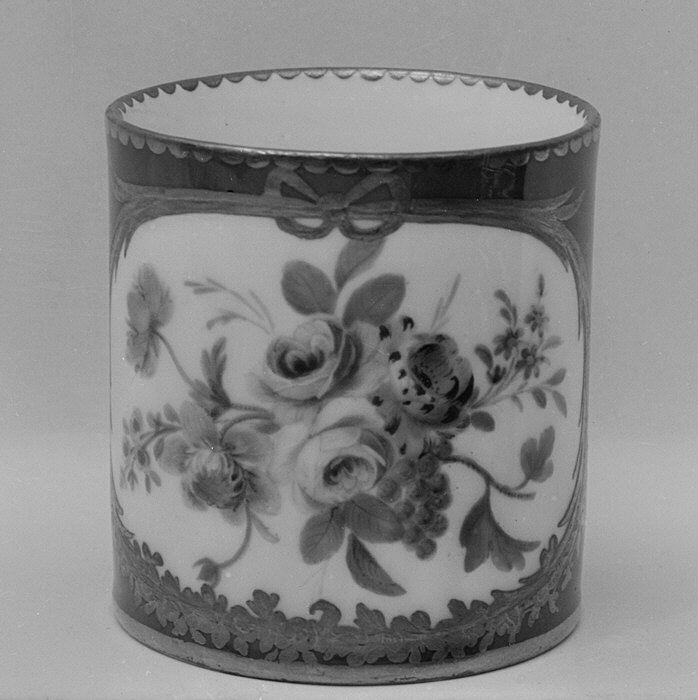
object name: cup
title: Cup (gobelet litron) (one of nine) (part of a service)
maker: sèvres manufactory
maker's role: manufactory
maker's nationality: french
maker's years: 1740-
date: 1786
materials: soft paste porcelain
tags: flowers